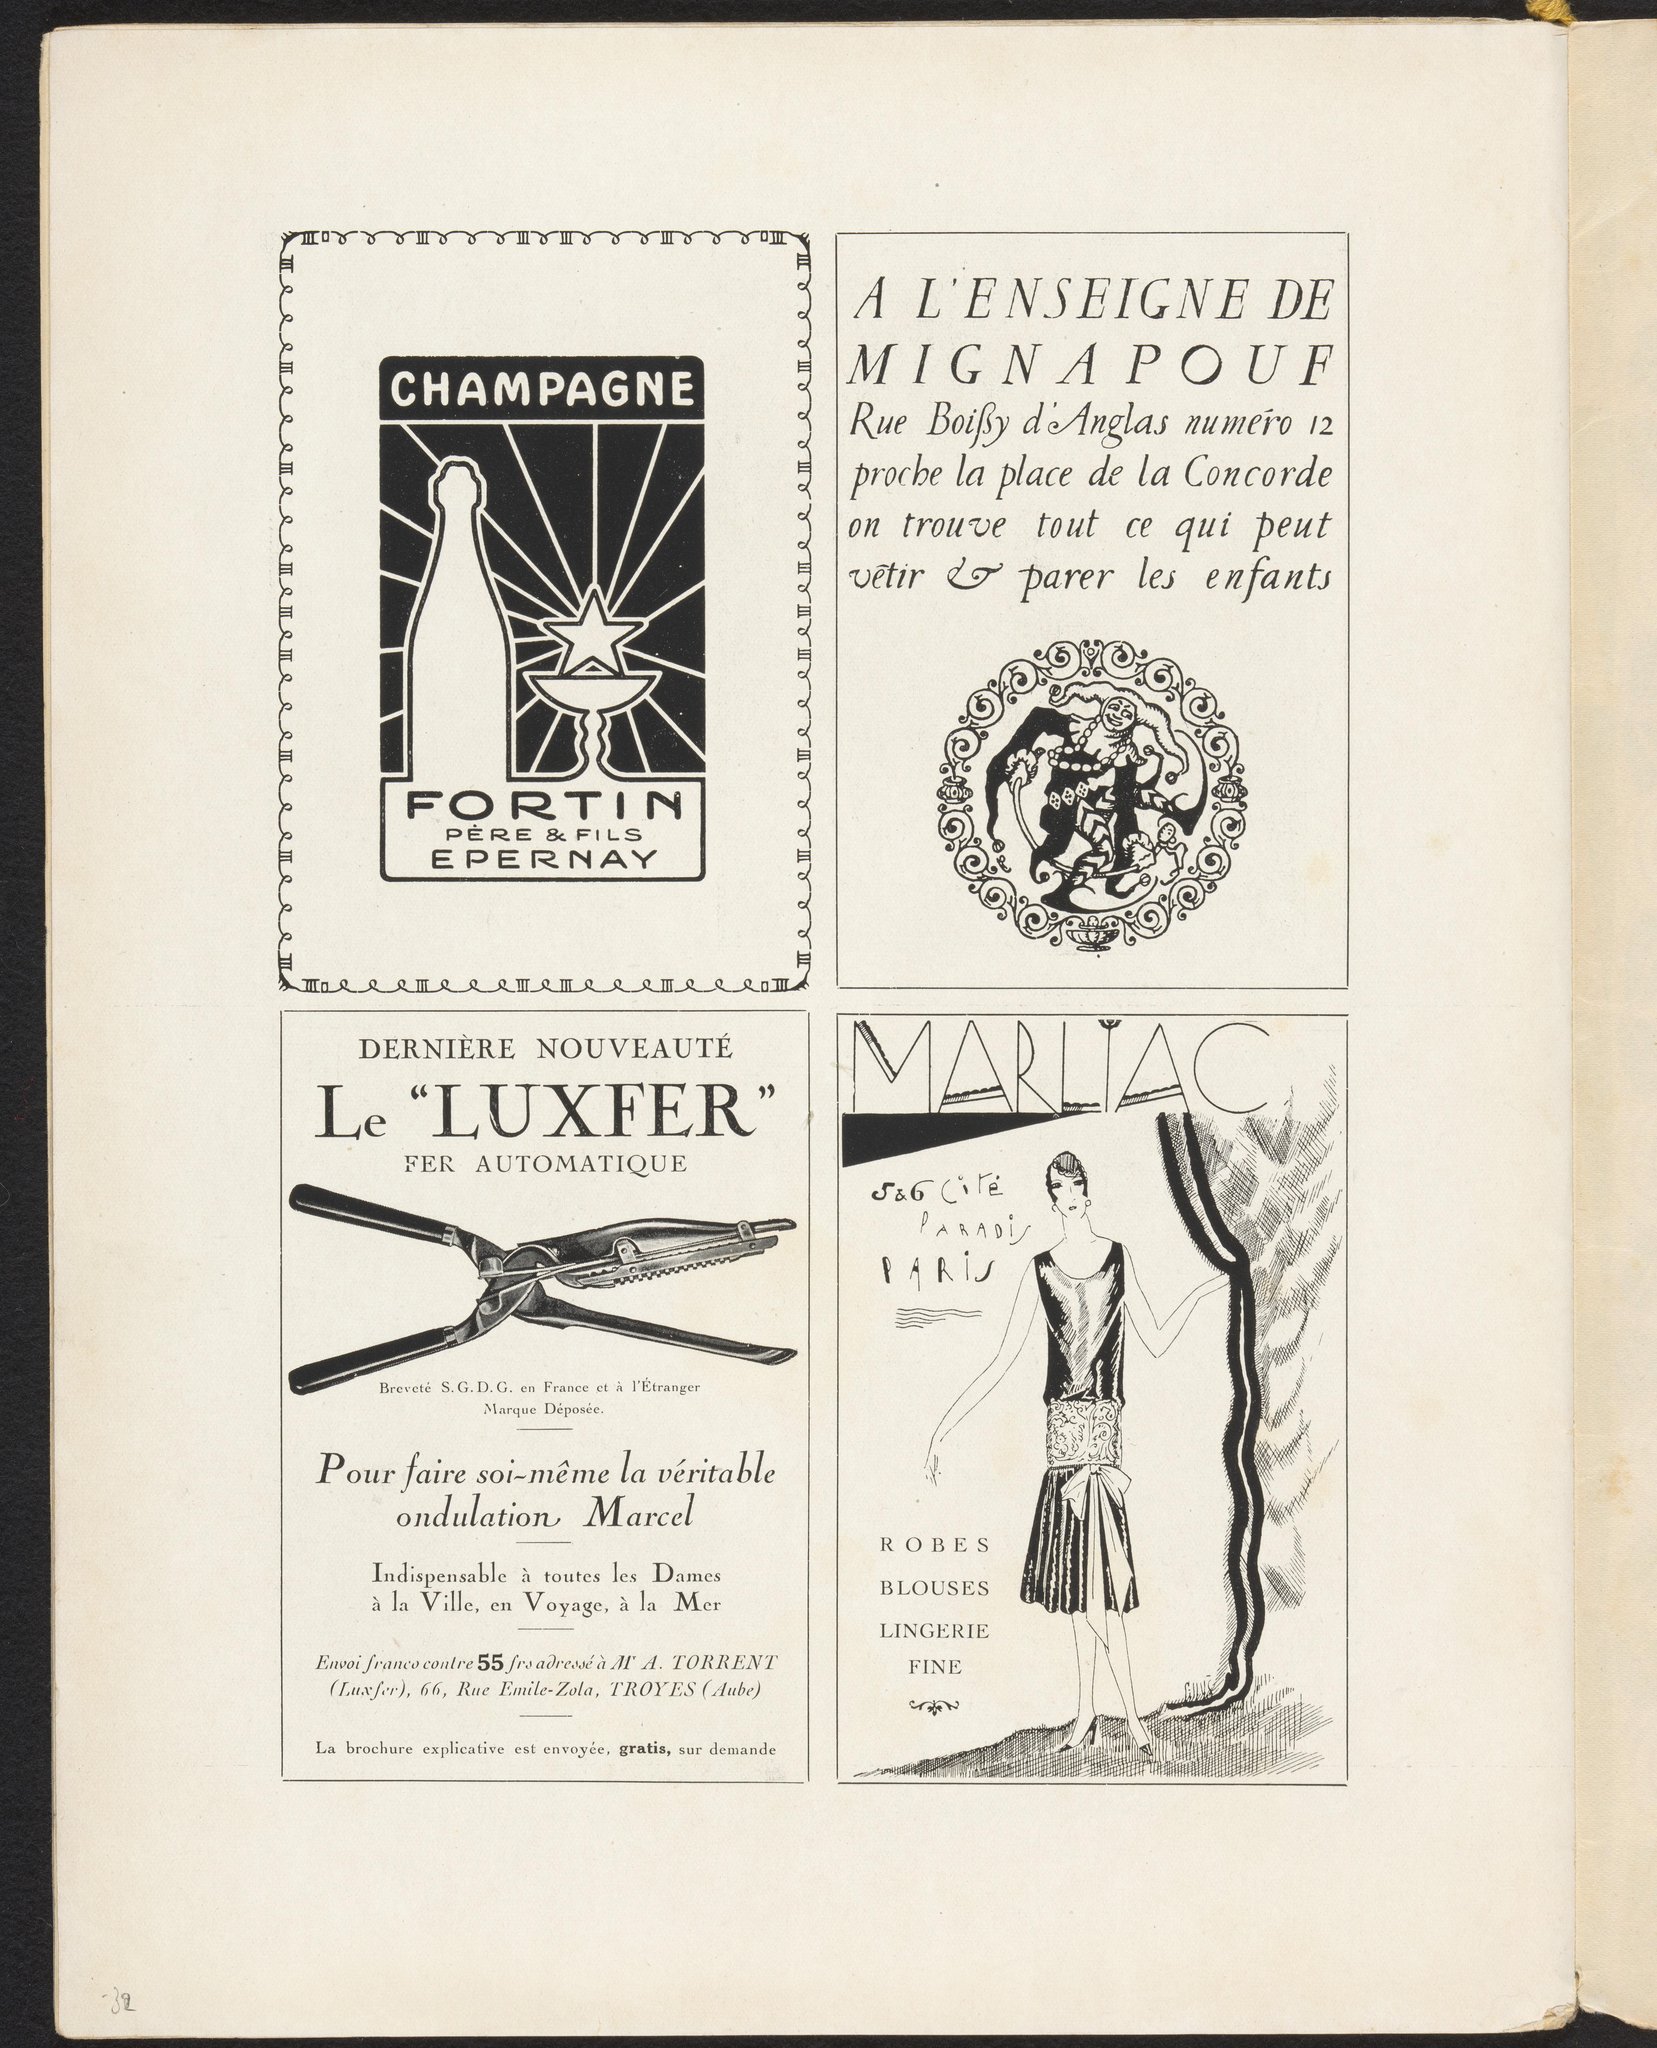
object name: magazine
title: Art - Goût - Beauté, Feuillets de l' élégance féminine, Février 1926, No. 66, 6e Année, p. 32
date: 1926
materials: paper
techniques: photography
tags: fashion plates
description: Advertenties voor verschillende producten. Pagina uit het modetijdschrift Art-Goût-Beauté (1920-1933).